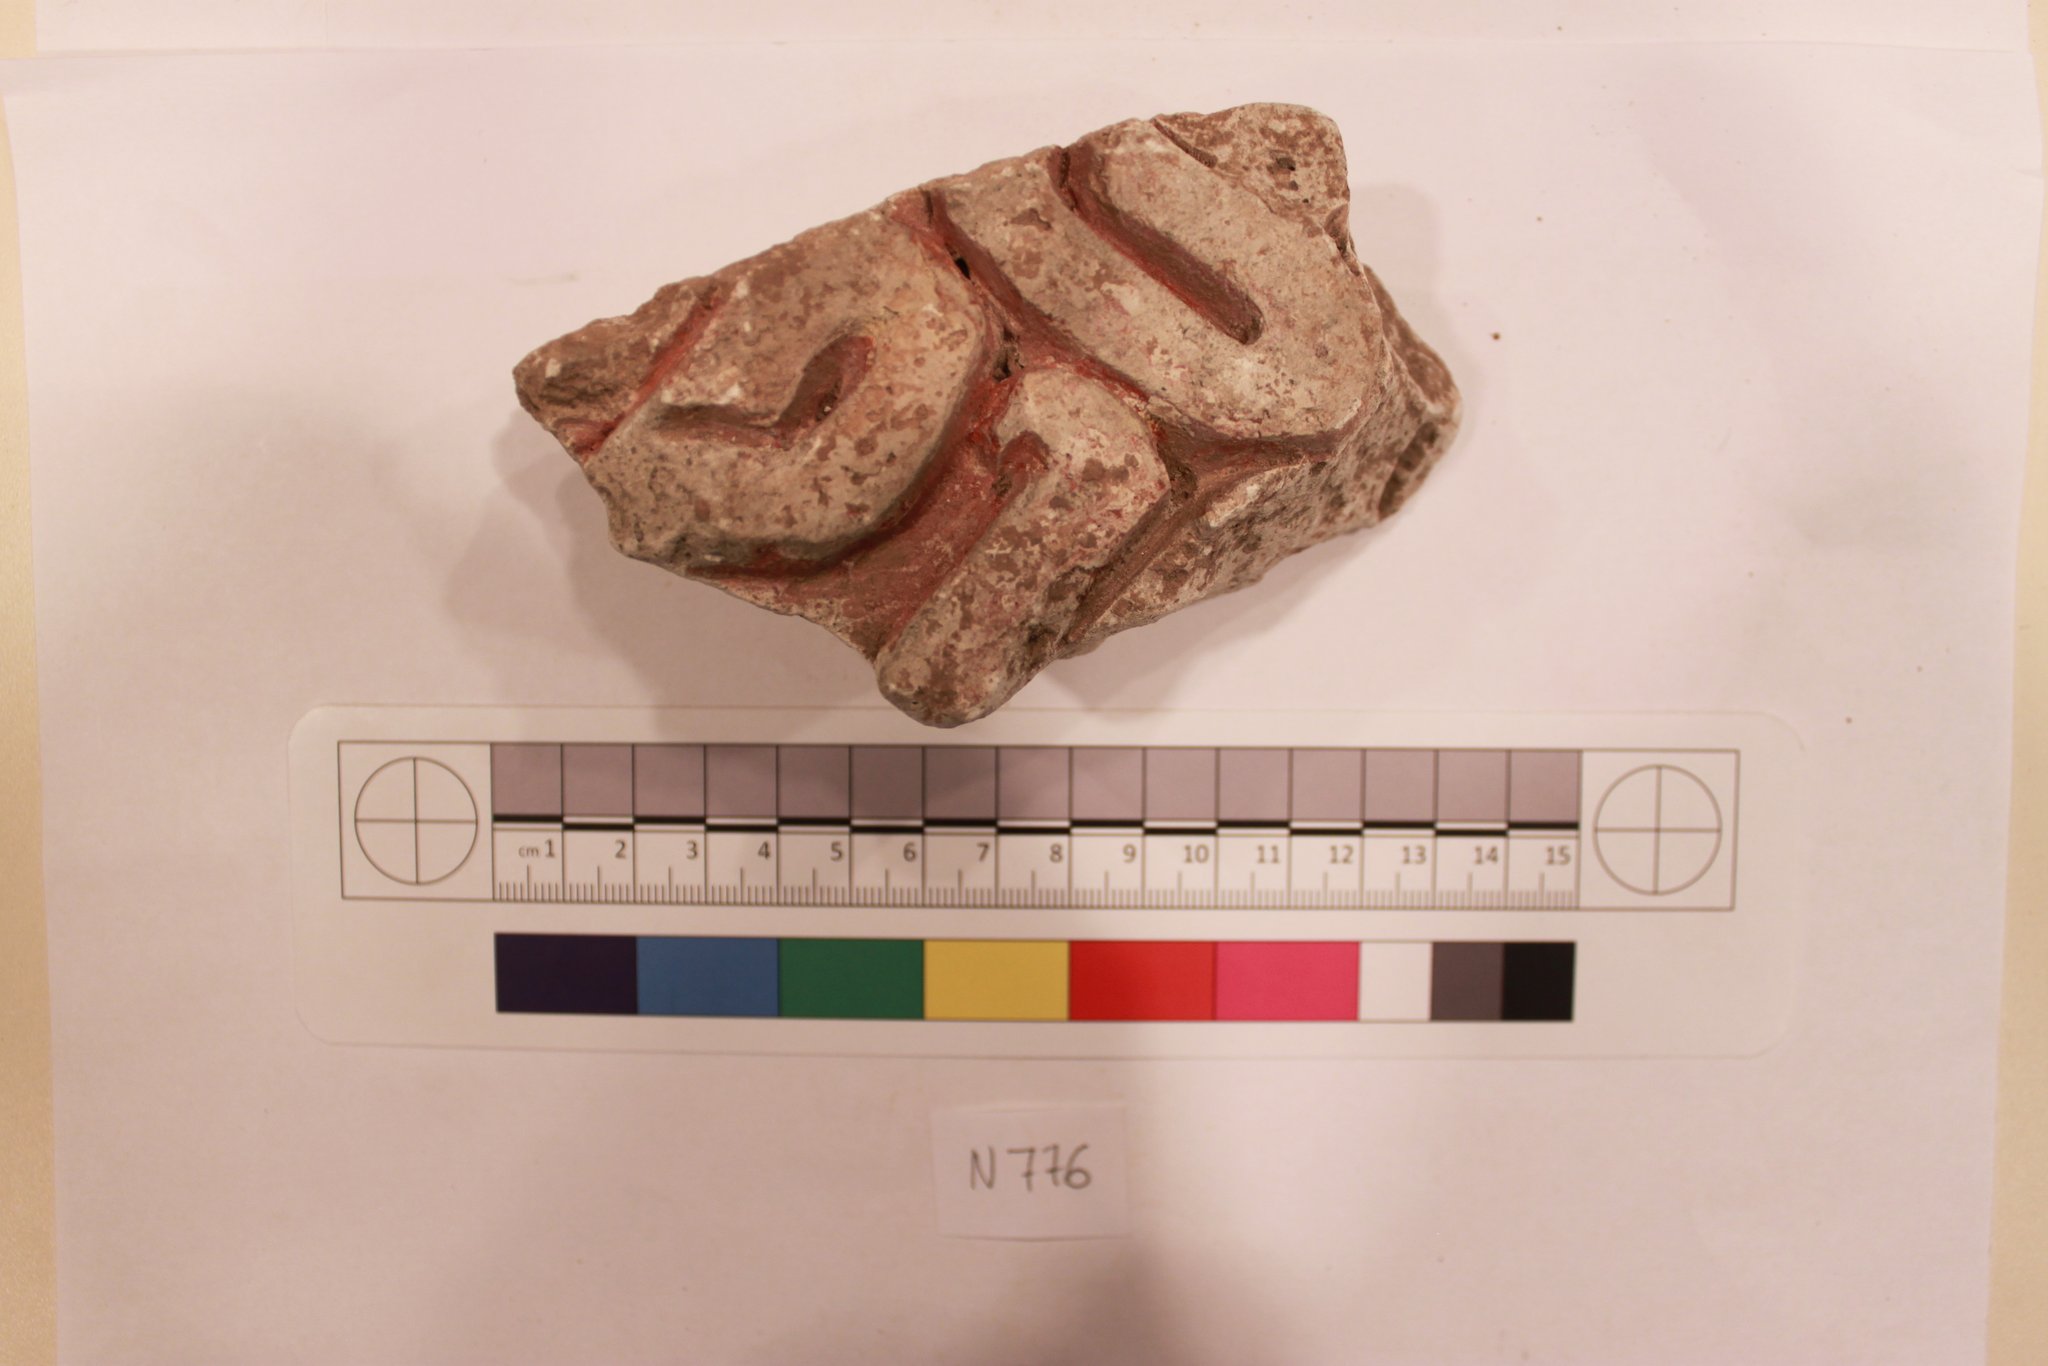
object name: fragment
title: Stucco Fragment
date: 701-1200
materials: plaster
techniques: carving, painting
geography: iran